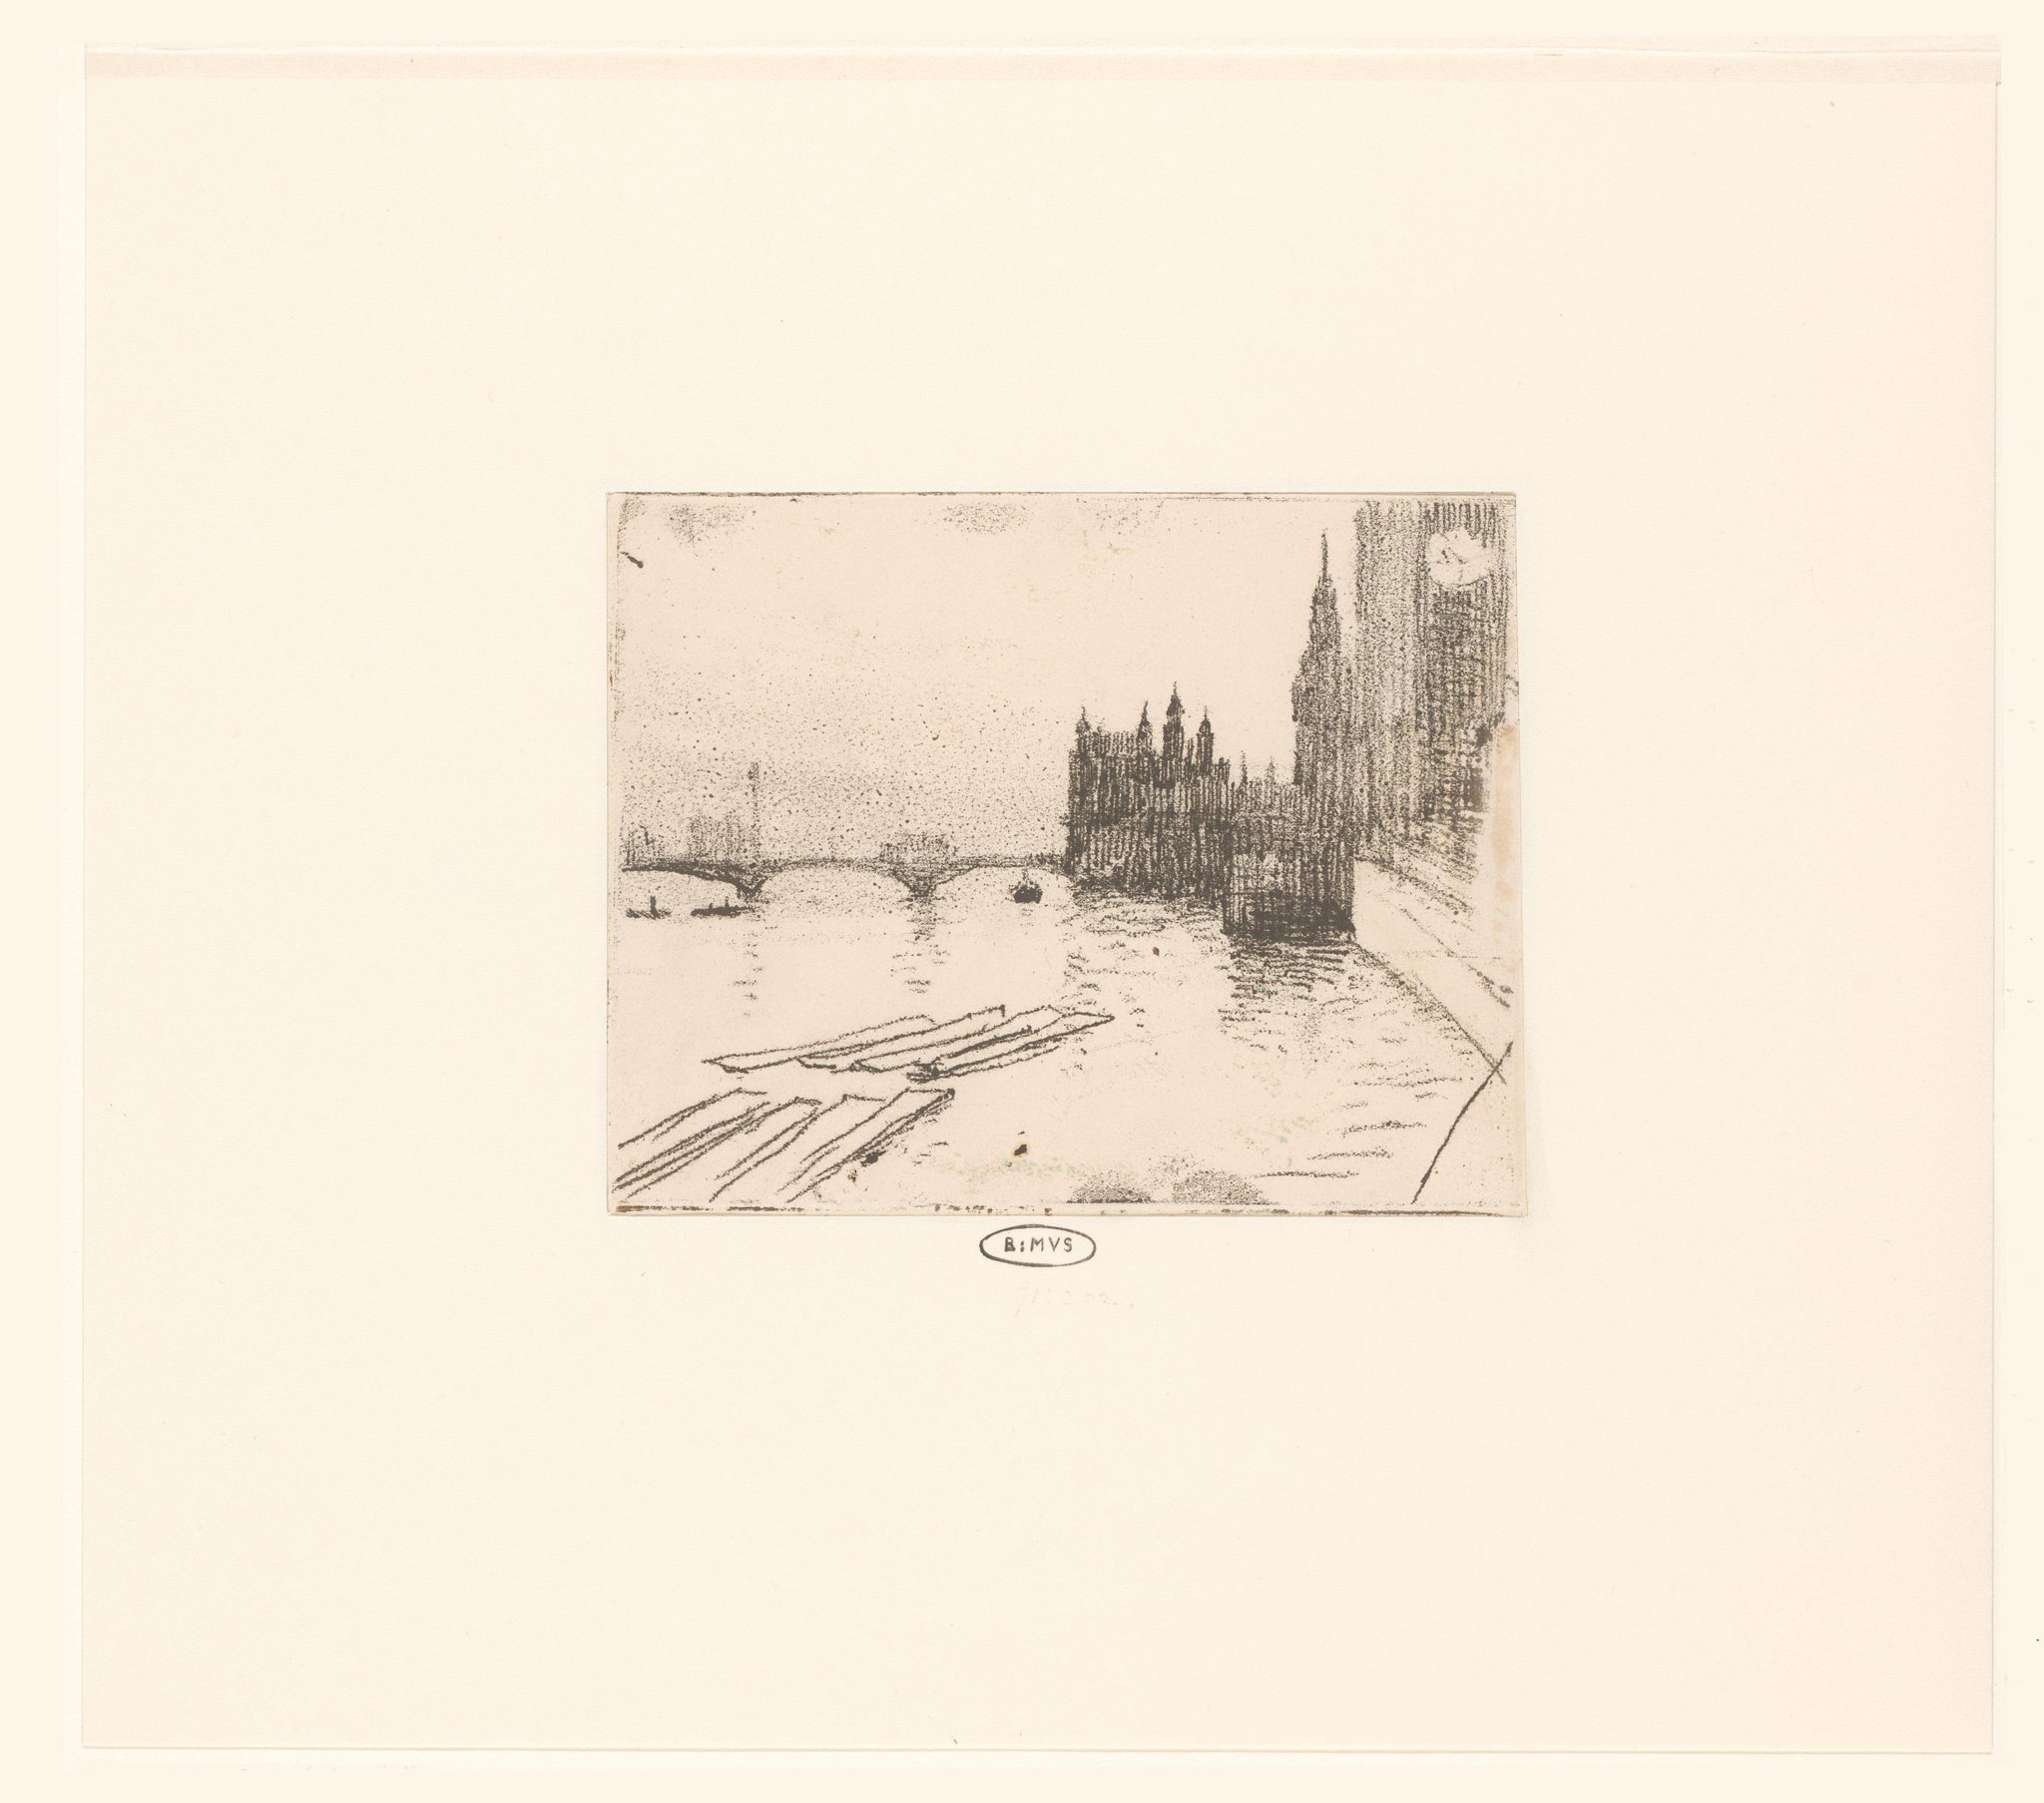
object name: print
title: Gezicht op de Houses of Parliament te Londen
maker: norbert goeneutte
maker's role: draughtsman, painter, print maker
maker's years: 1854-1894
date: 1888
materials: paper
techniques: etching, soft ground etching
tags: city-view in general; 'veduta', palace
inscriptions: collector's mark: Lugt 2228